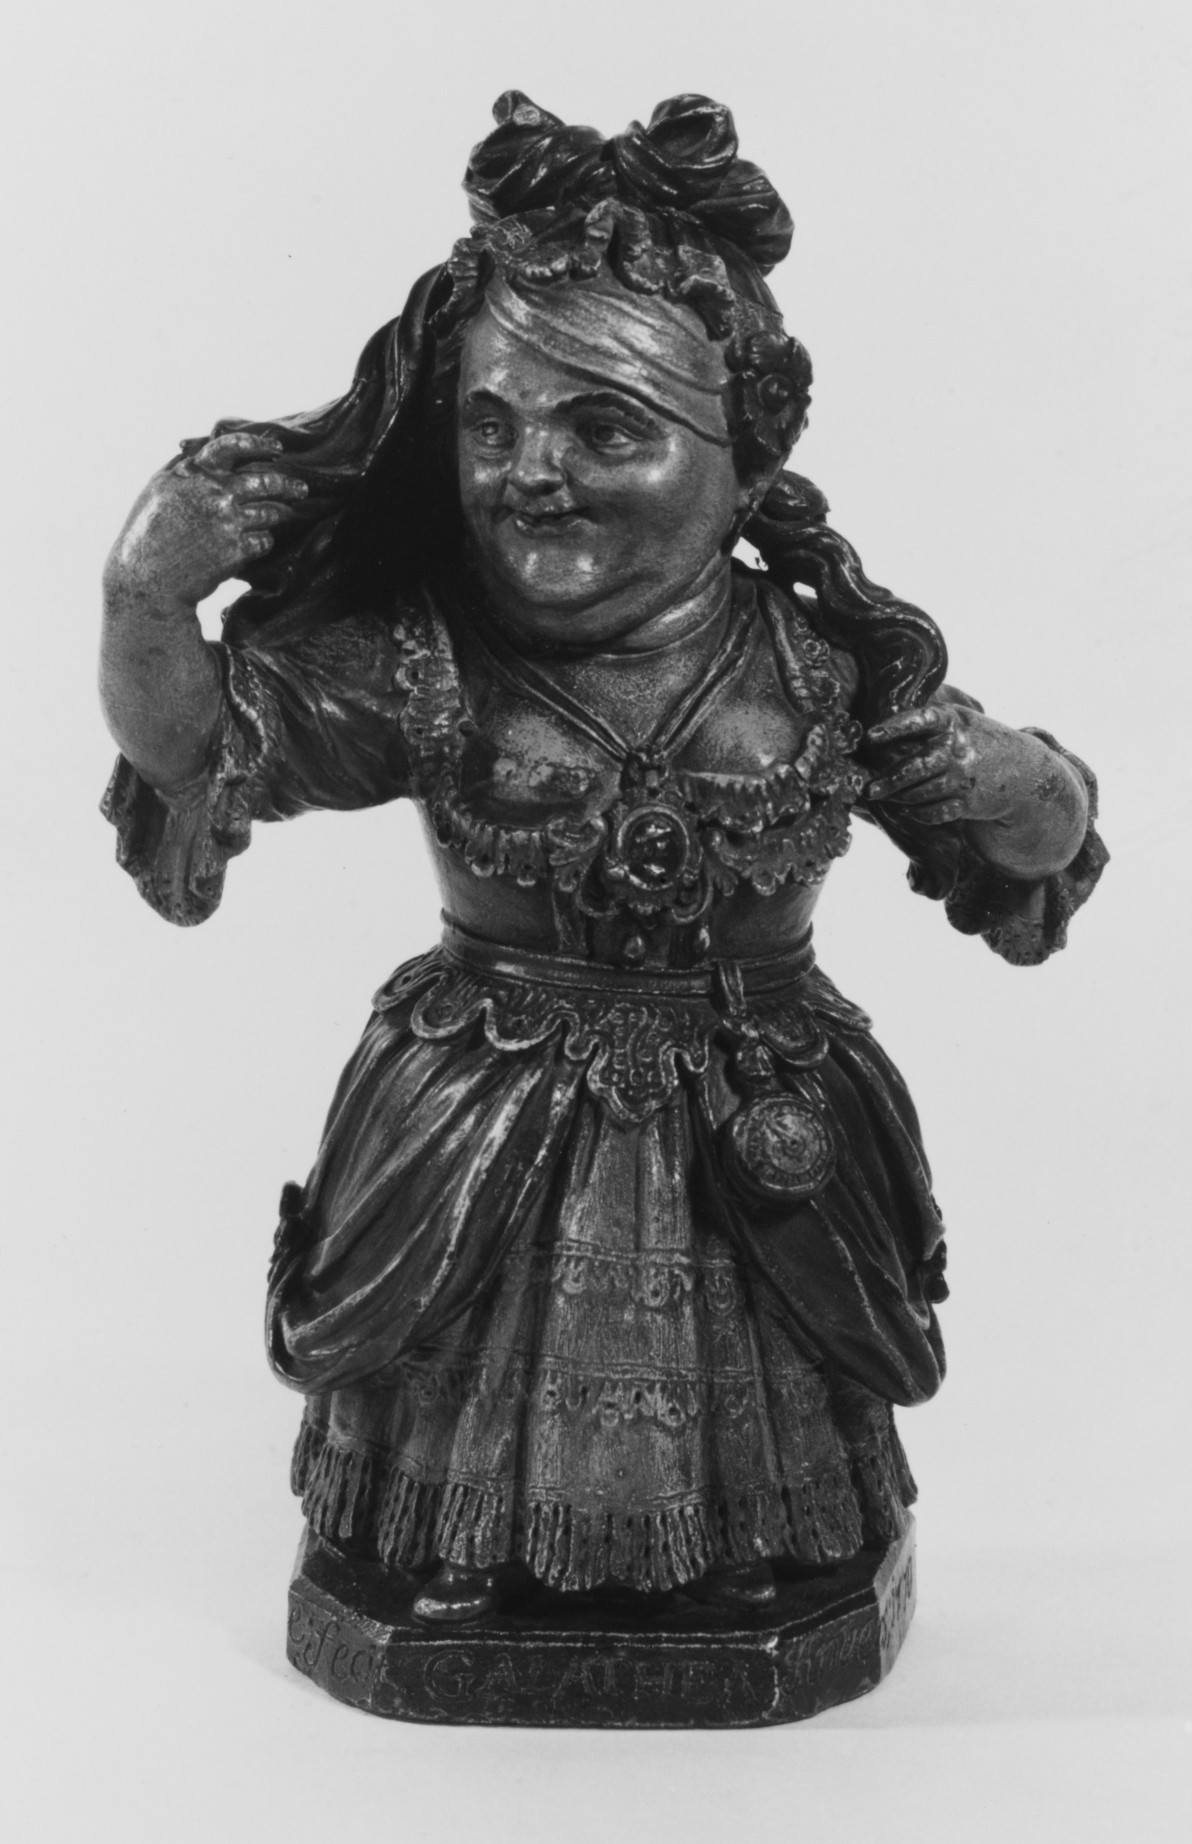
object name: statuette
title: Dwarf as Galatea (one of a pair)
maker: walter pompe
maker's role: artist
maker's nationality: flemish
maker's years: 1703-1777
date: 1770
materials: terracotta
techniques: casting, polychrome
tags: galatea